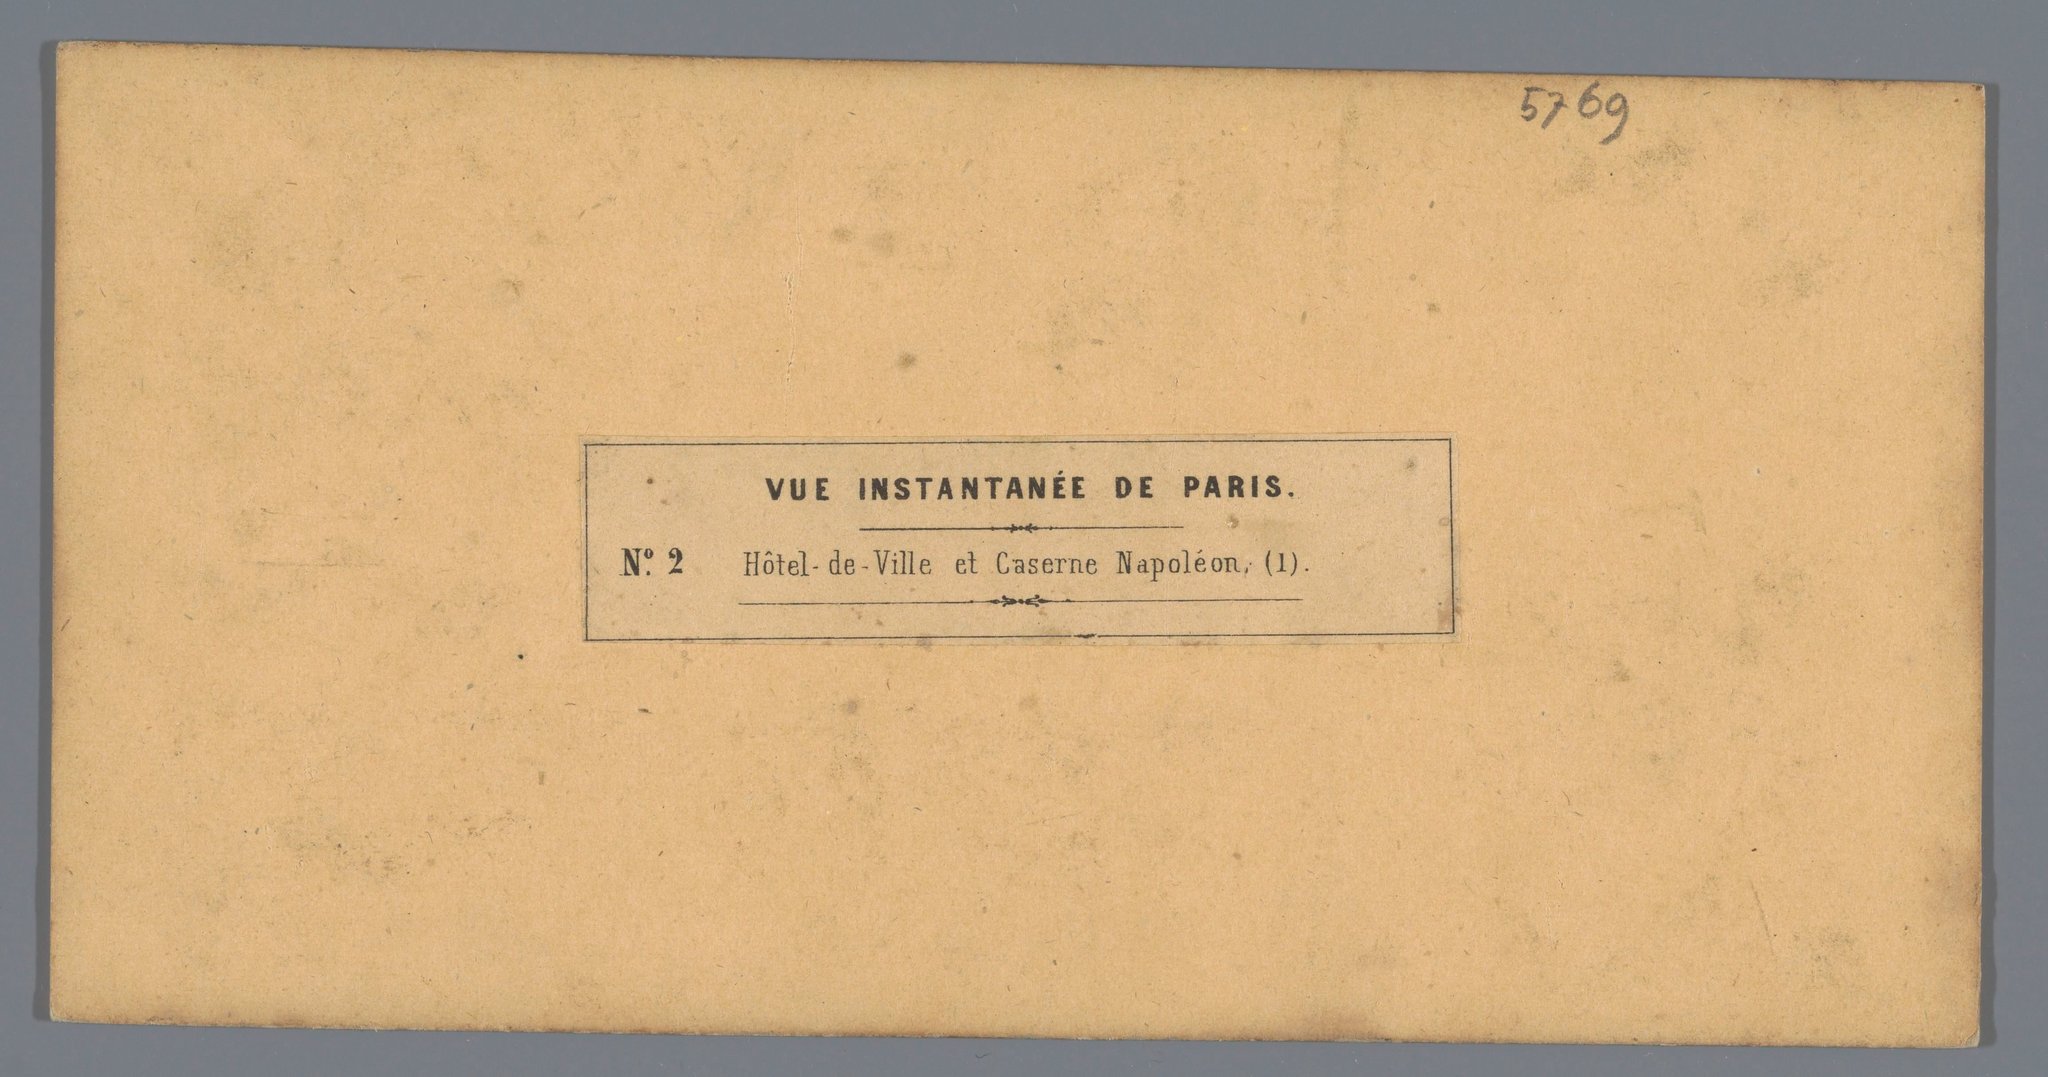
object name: stereograph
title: Hôtel-de-Ville et Caserne Napoléon (1)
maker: Anonymous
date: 1850-1880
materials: cardboard, photographic support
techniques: albumen print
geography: paris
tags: animal traction, animal-drawn vehicle (carriage etc.), townhall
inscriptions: number: ‘No. 2’